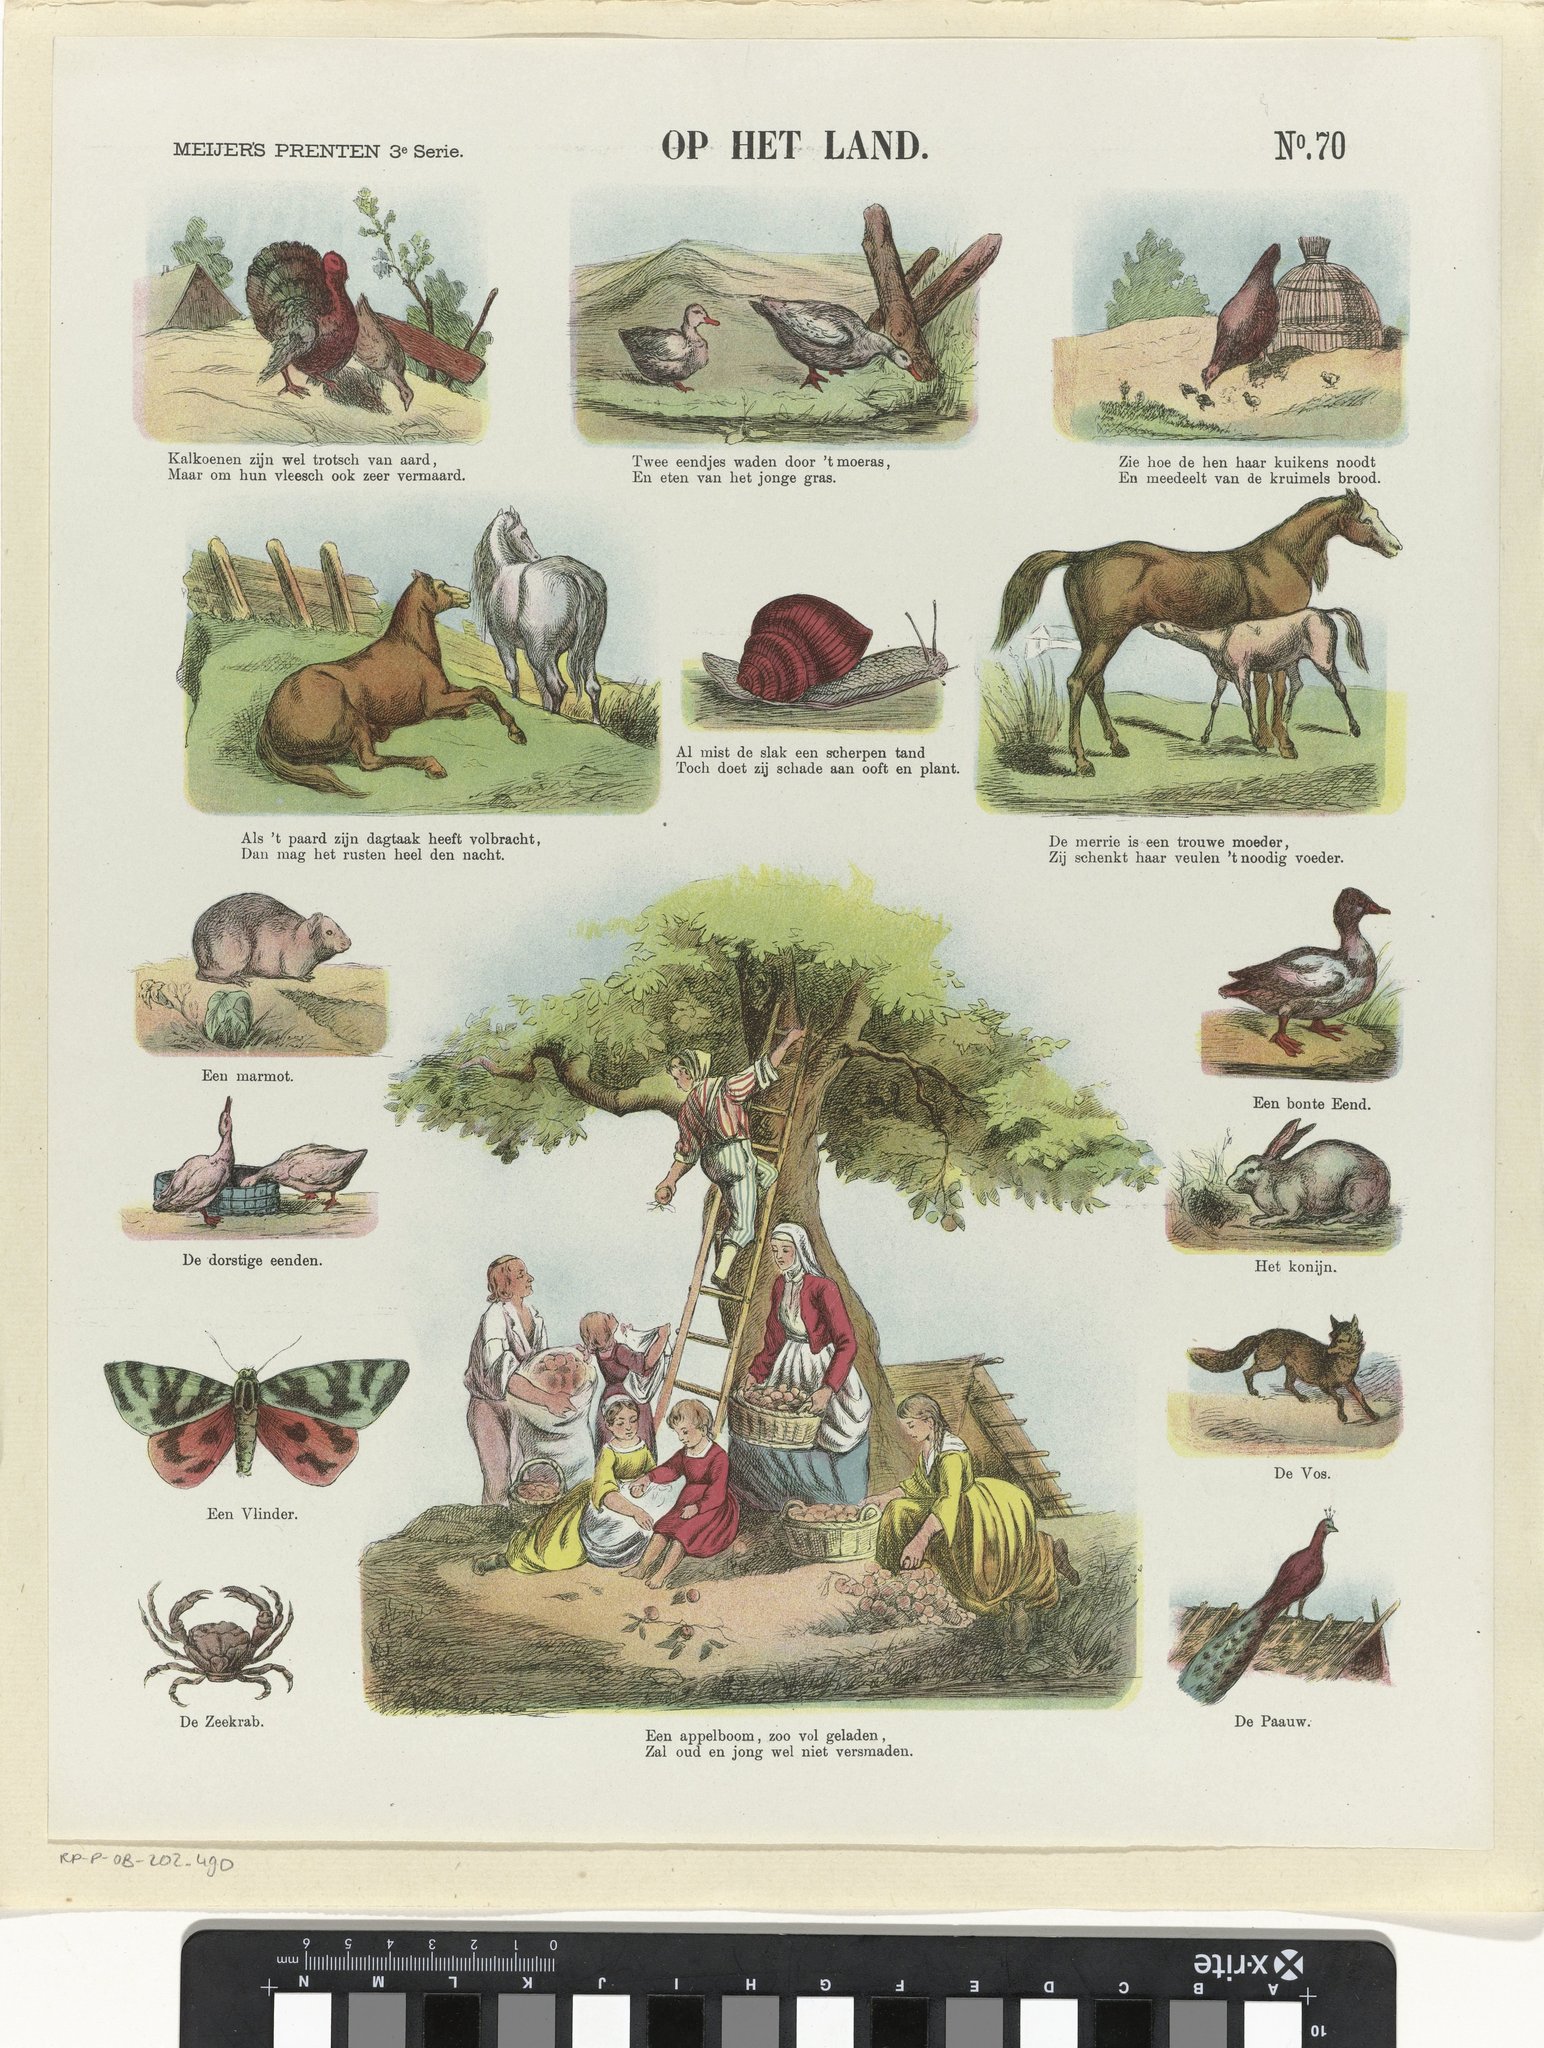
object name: popular print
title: Meijer's prenten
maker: Anonymous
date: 1878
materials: paper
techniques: lithograph, letterpress printing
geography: amsterdam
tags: animals, horse, water-birds: duck, walker and runner birds: turkey, beasts of prey, predatory animals: fox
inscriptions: collector's mark: Lugt 2760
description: Blad met 15 voorstellingen van dieren op het platteland, waaronder eenden, kalkoenen, paarden en een marmot. Onder elke voorstelling een onderschrift. Genummerd rechtsboven: No. 70.